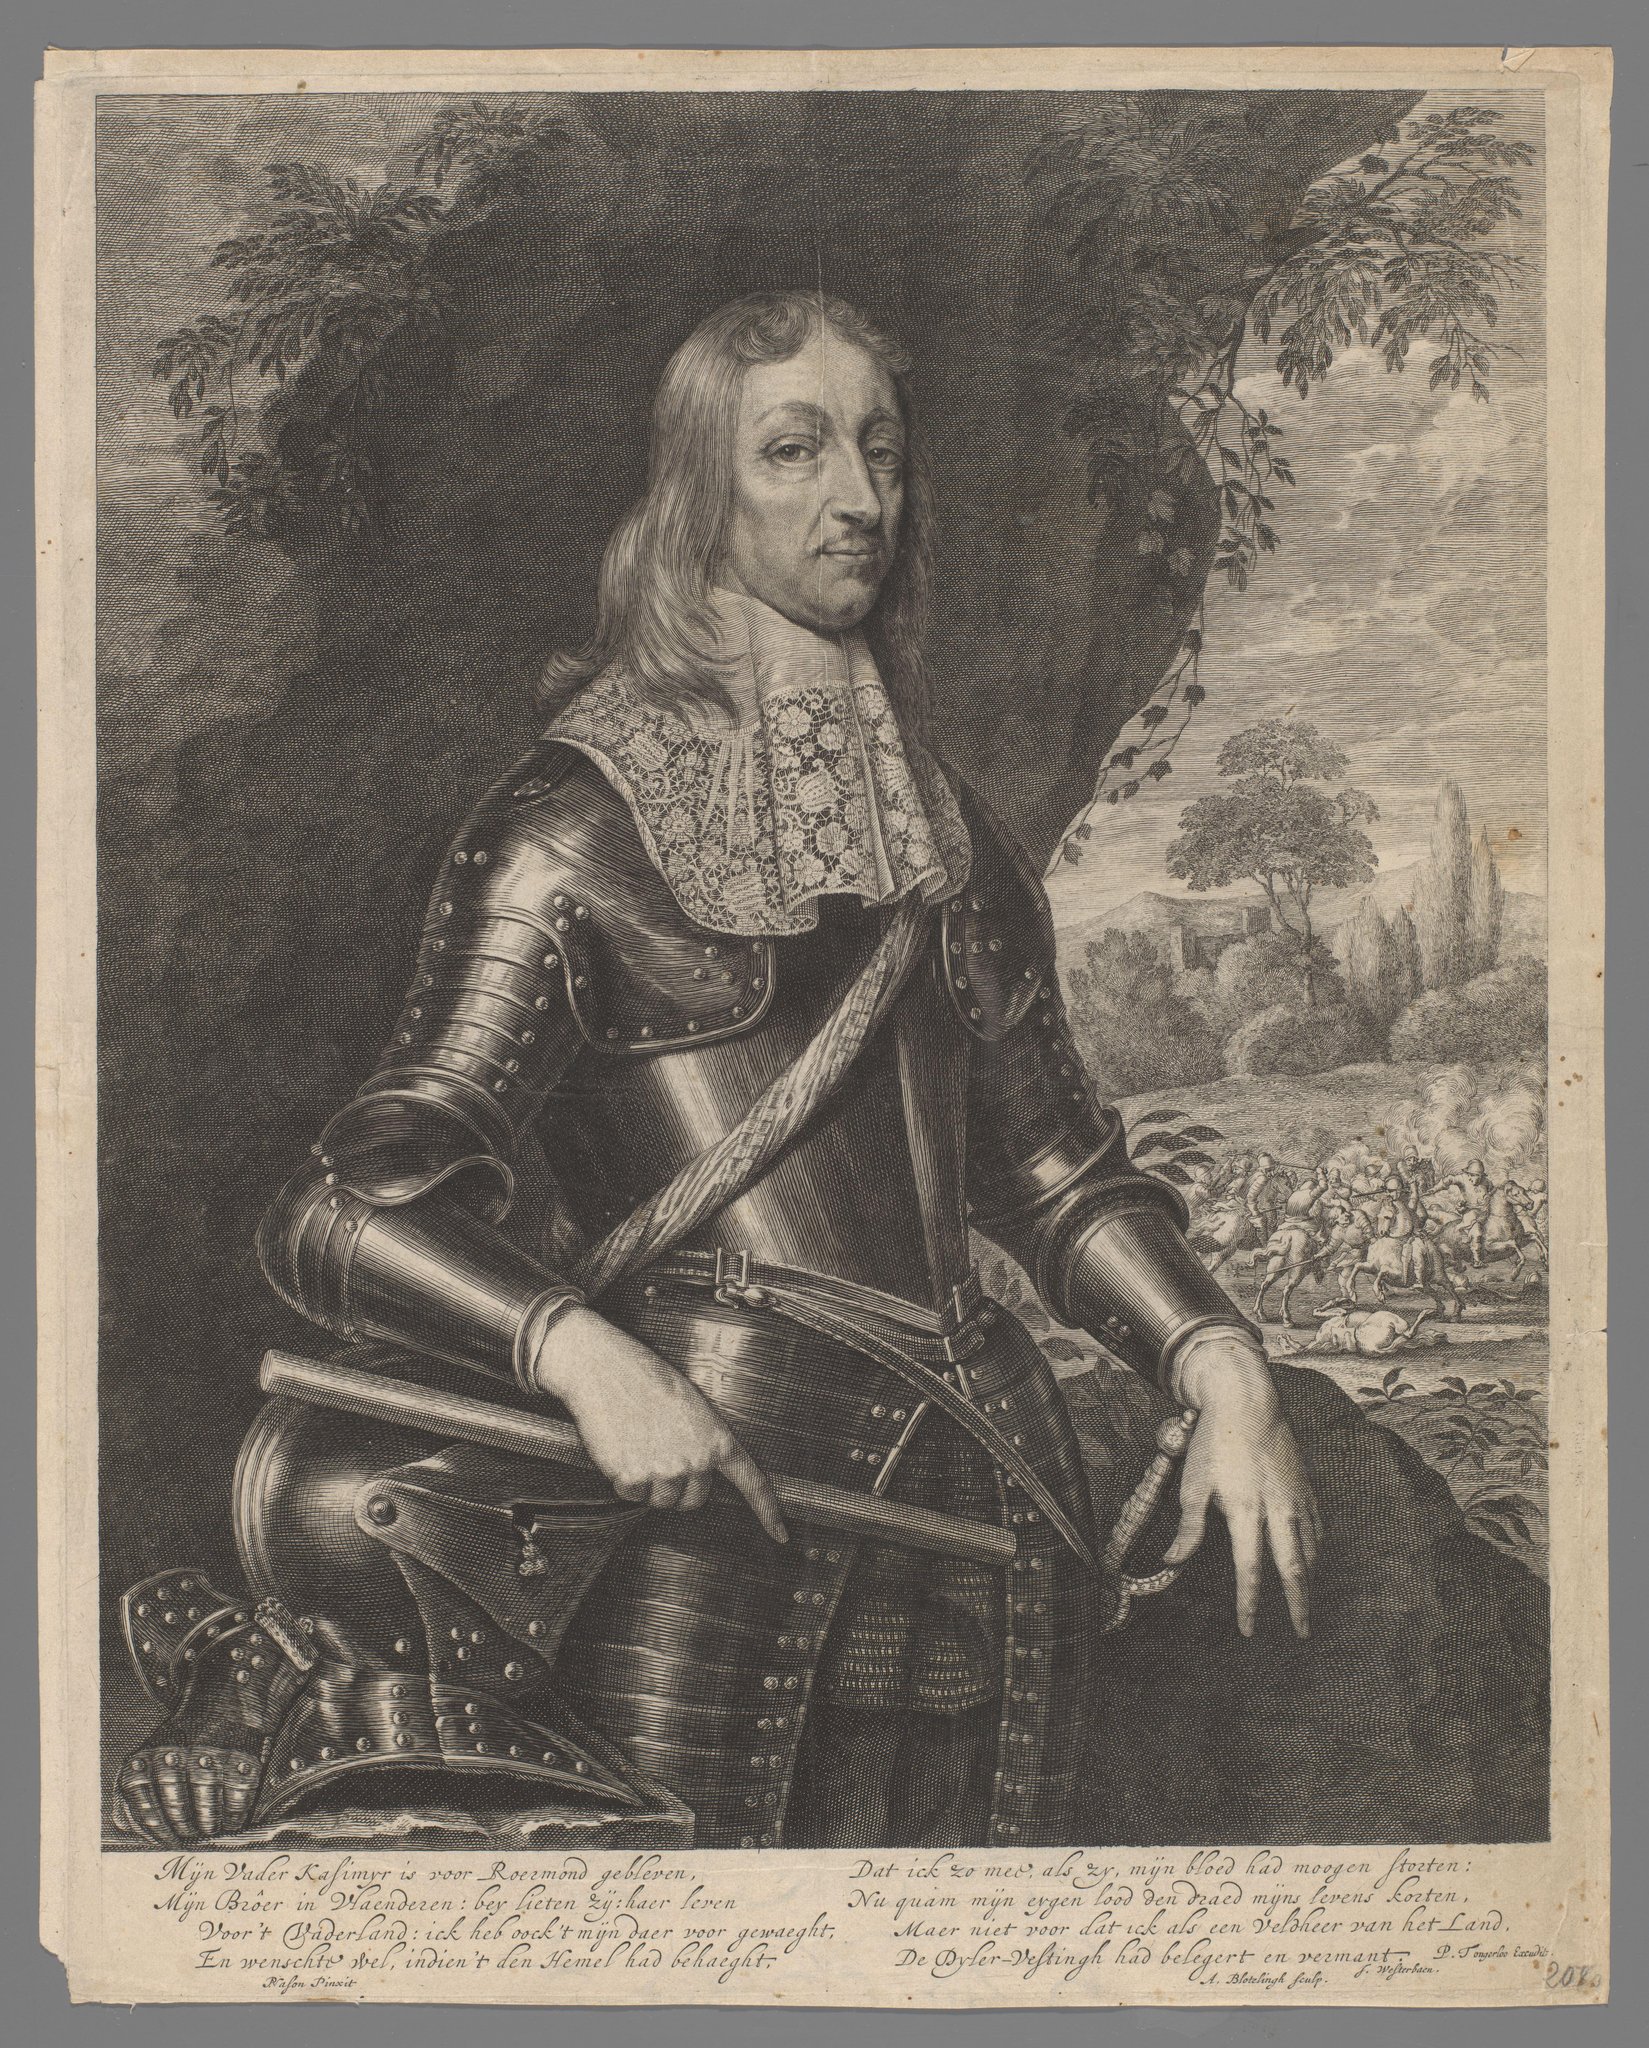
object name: print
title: Portret van Willem Frederik, graaf van Nassau-Dietz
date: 1682-1707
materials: paper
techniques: engraving, etching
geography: the hague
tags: arnhem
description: Portret van Willem Frederik. In zijn rechterhand een commandostaf. Op de achtergrond een ruitergevecht. In de ondermarge twee kolommen met elk vier regels Nederlandse tekst.